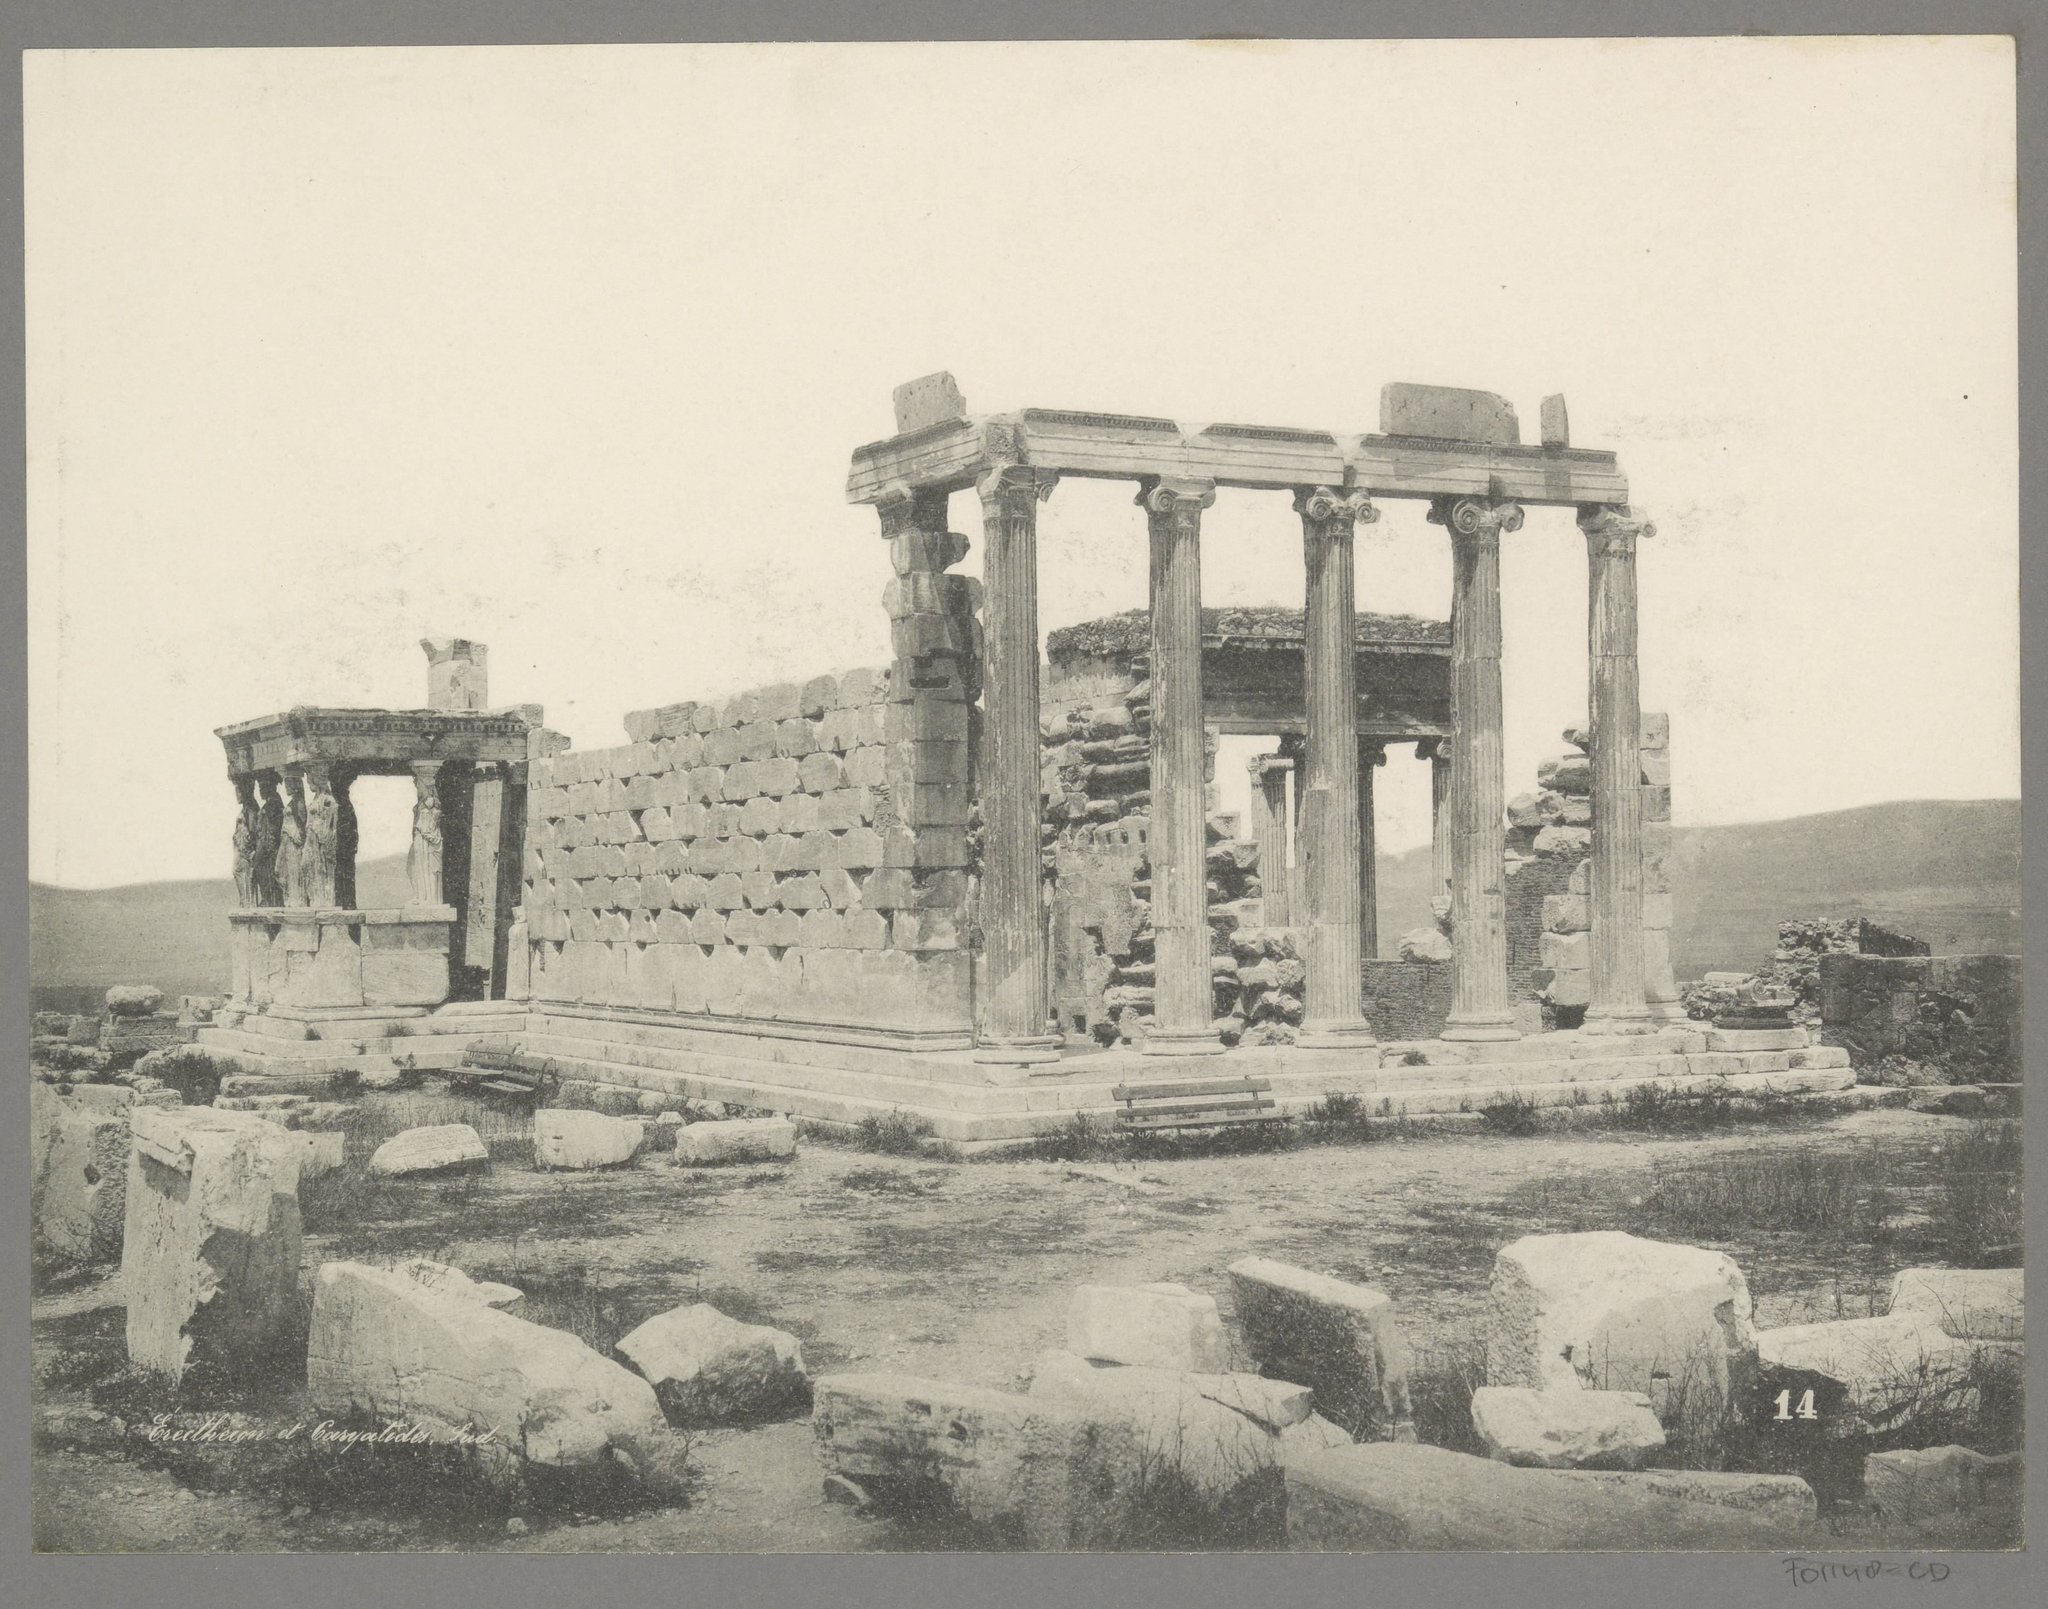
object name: album leaf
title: Érectheion et Caryatides, Sud.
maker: Anonymous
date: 1895-1905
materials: paper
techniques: photograph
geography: acropolis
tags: caryatids ~ architecture, temple, shrine ~ greek religion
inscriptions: number: ‘14’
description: Onderdeel van Reisalbum met foto's van bezienswaardigheden in Griekenland en Egypte.